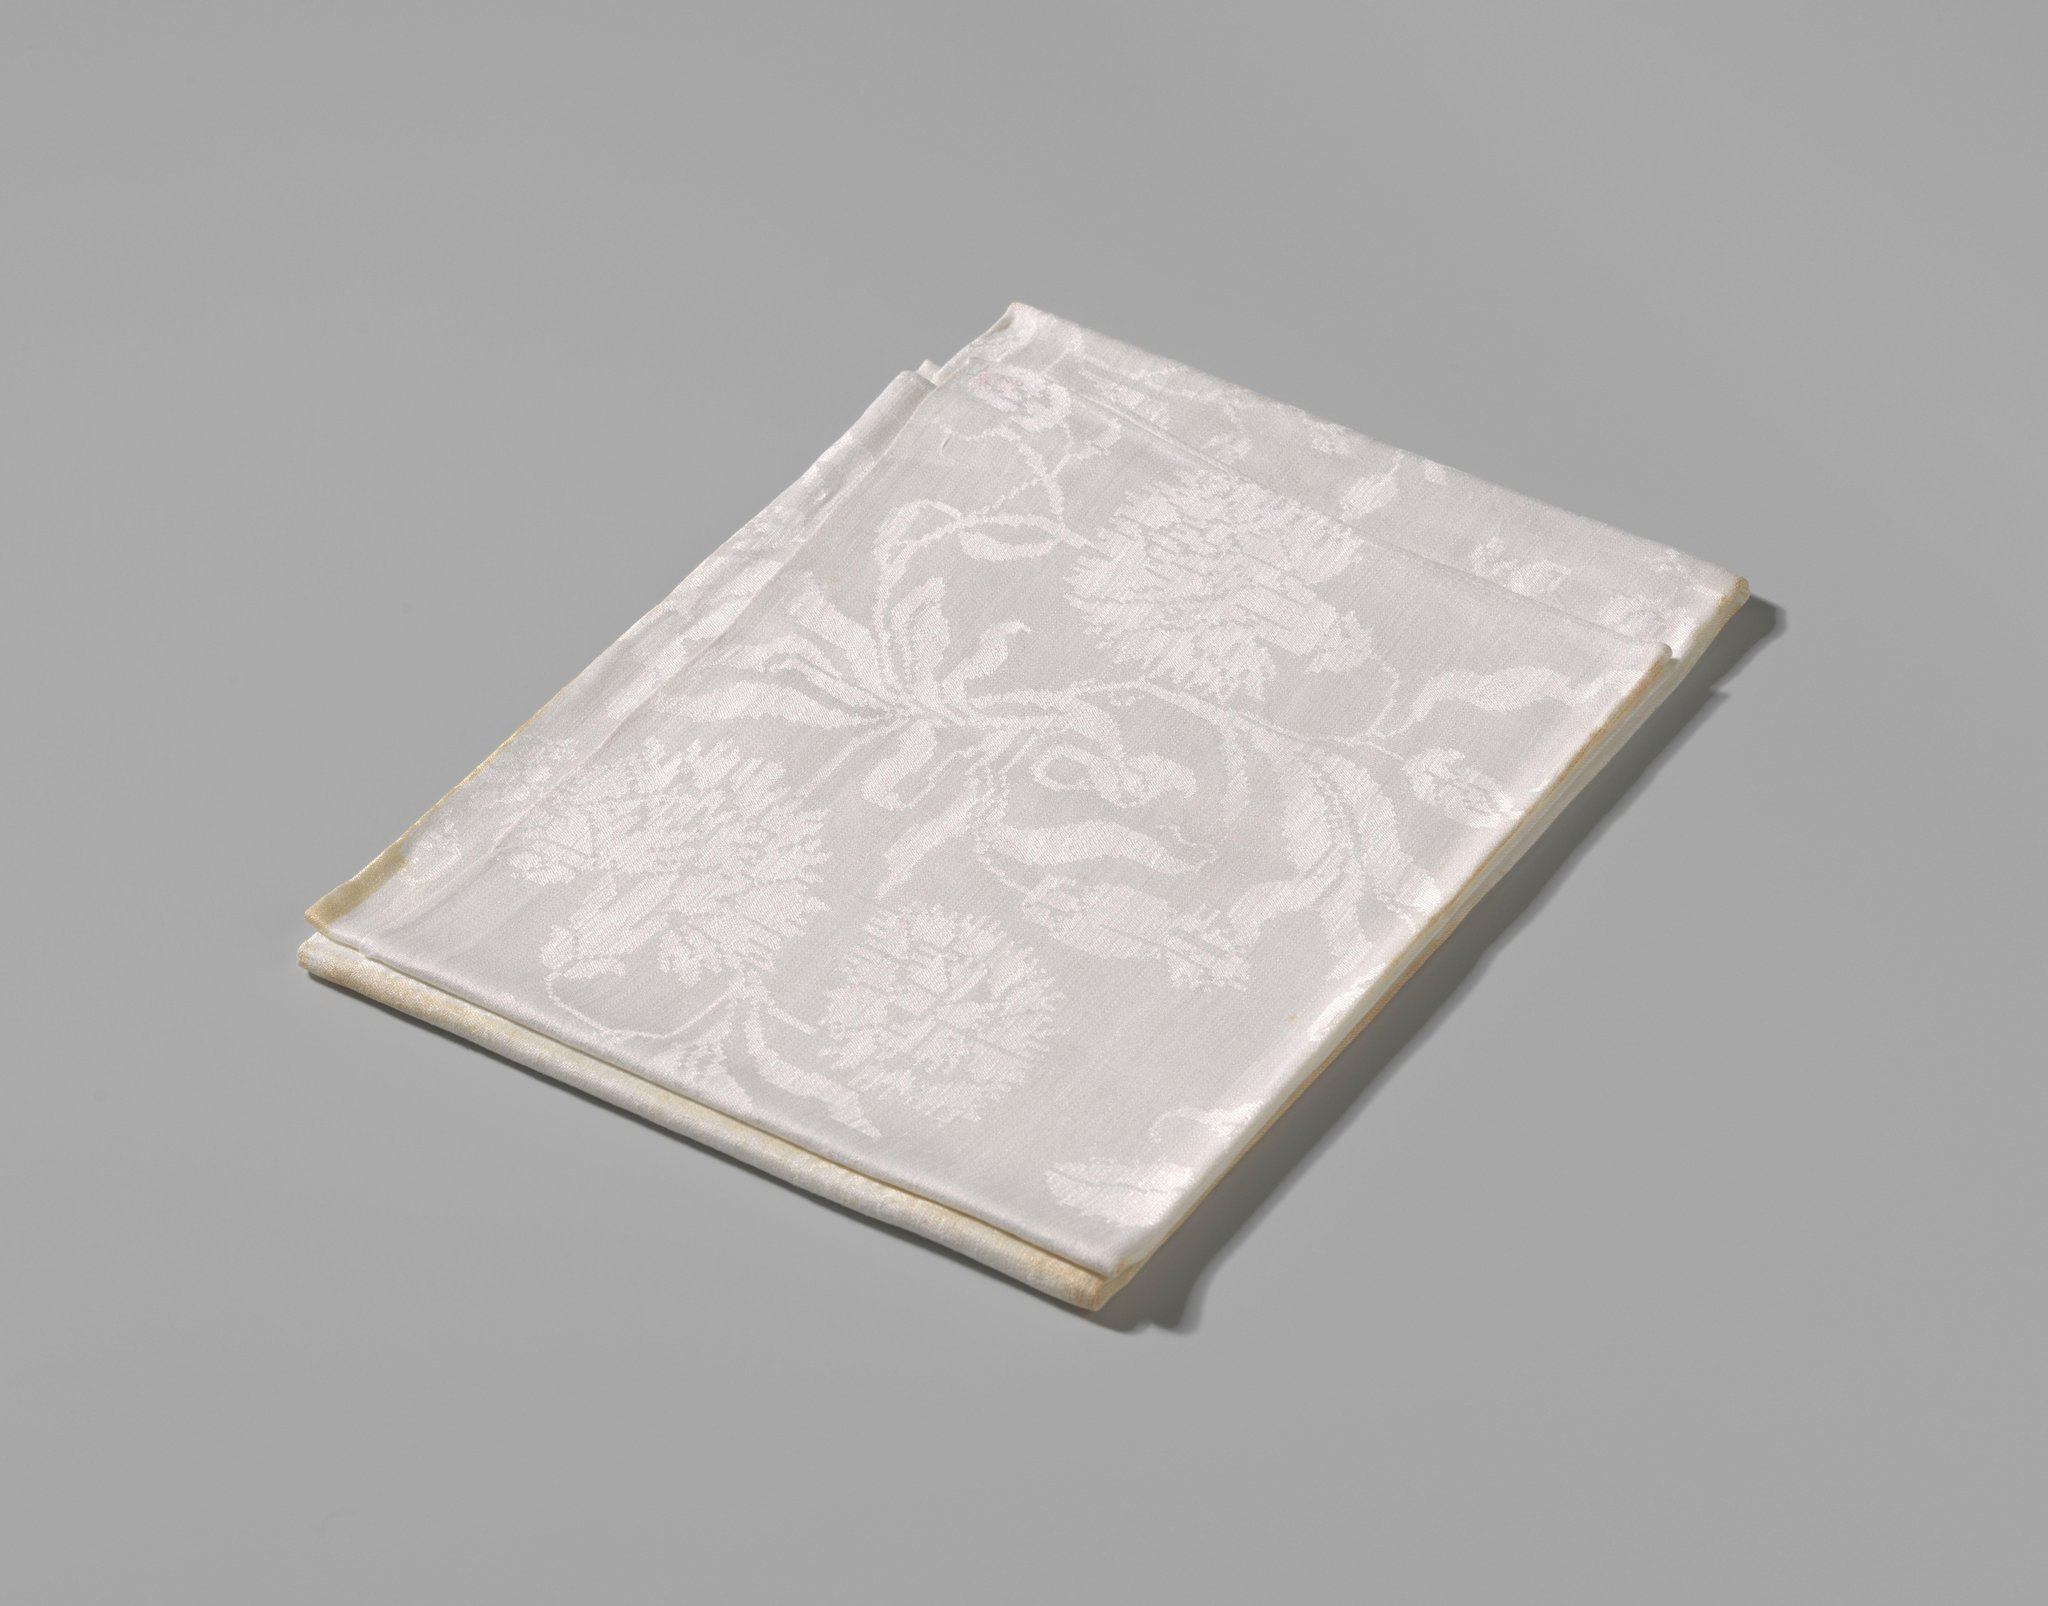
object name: napkin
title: Servet van linnendamast met een bloempatroon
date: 1750-1800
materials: linen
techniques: damask, weave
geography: flanders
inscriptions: : ‘SM’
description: Servet van linnendamast met een beker met bloemen. Het servet is gemerkt: SM. Bij het servet hoort een tafellaken (BK-1980-106).